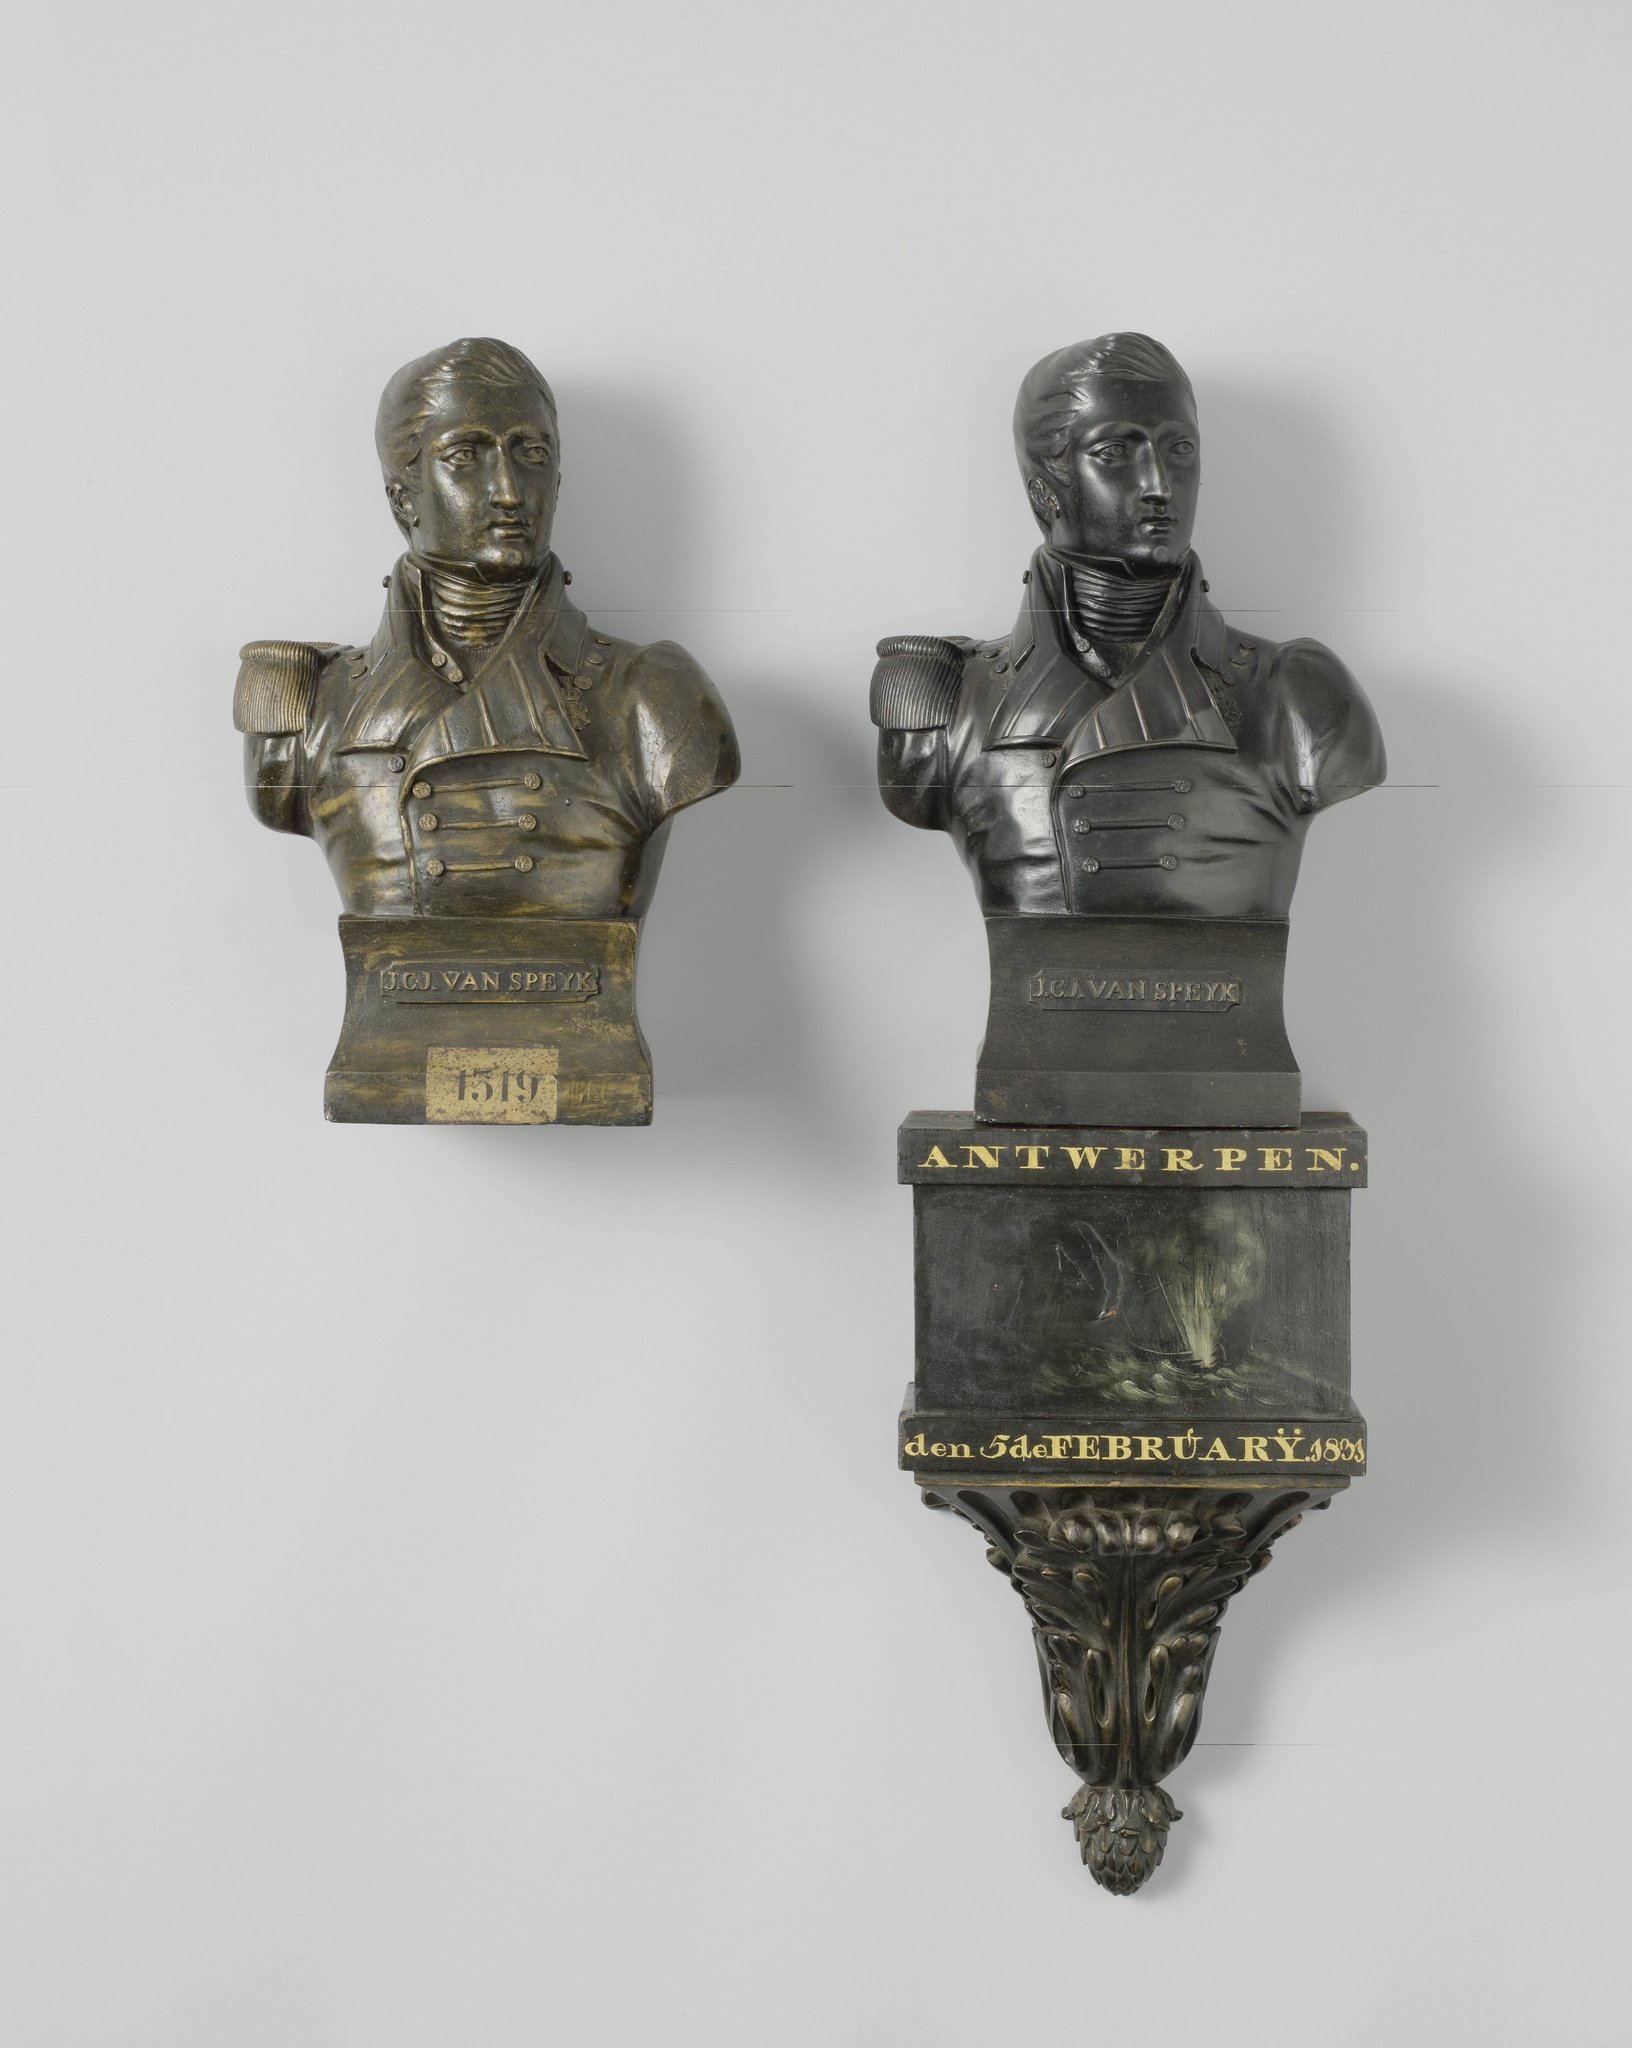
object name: bust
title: Bust of J.C.J. van Speyk (1802-1831)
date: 1832-1858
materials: bronze, iron, wood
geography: deventer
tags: amsterdam, antwerp, jan van speyk, chest, bust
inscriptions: inscription, on the bust: ‘J.C.J. VAN SPEYK’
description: Twee busten van J.C.J. van Speyk en één sokkel. Twee identieke bronzen busten van een Nederlands marine-officier, het hoofd licht naar links gedraaid. Hij draagt een uniform en een Militaire Willemsorde. Bij de busten hoort één wandsokkel, waarop de ontploffing van het schip van de geportretteerde is afgebeeld. De sokkel is onderaan met een guirlande afgewerkt. [Gecombineerde beschrijving. Buste met label MC = NG-MC-1319-1.]